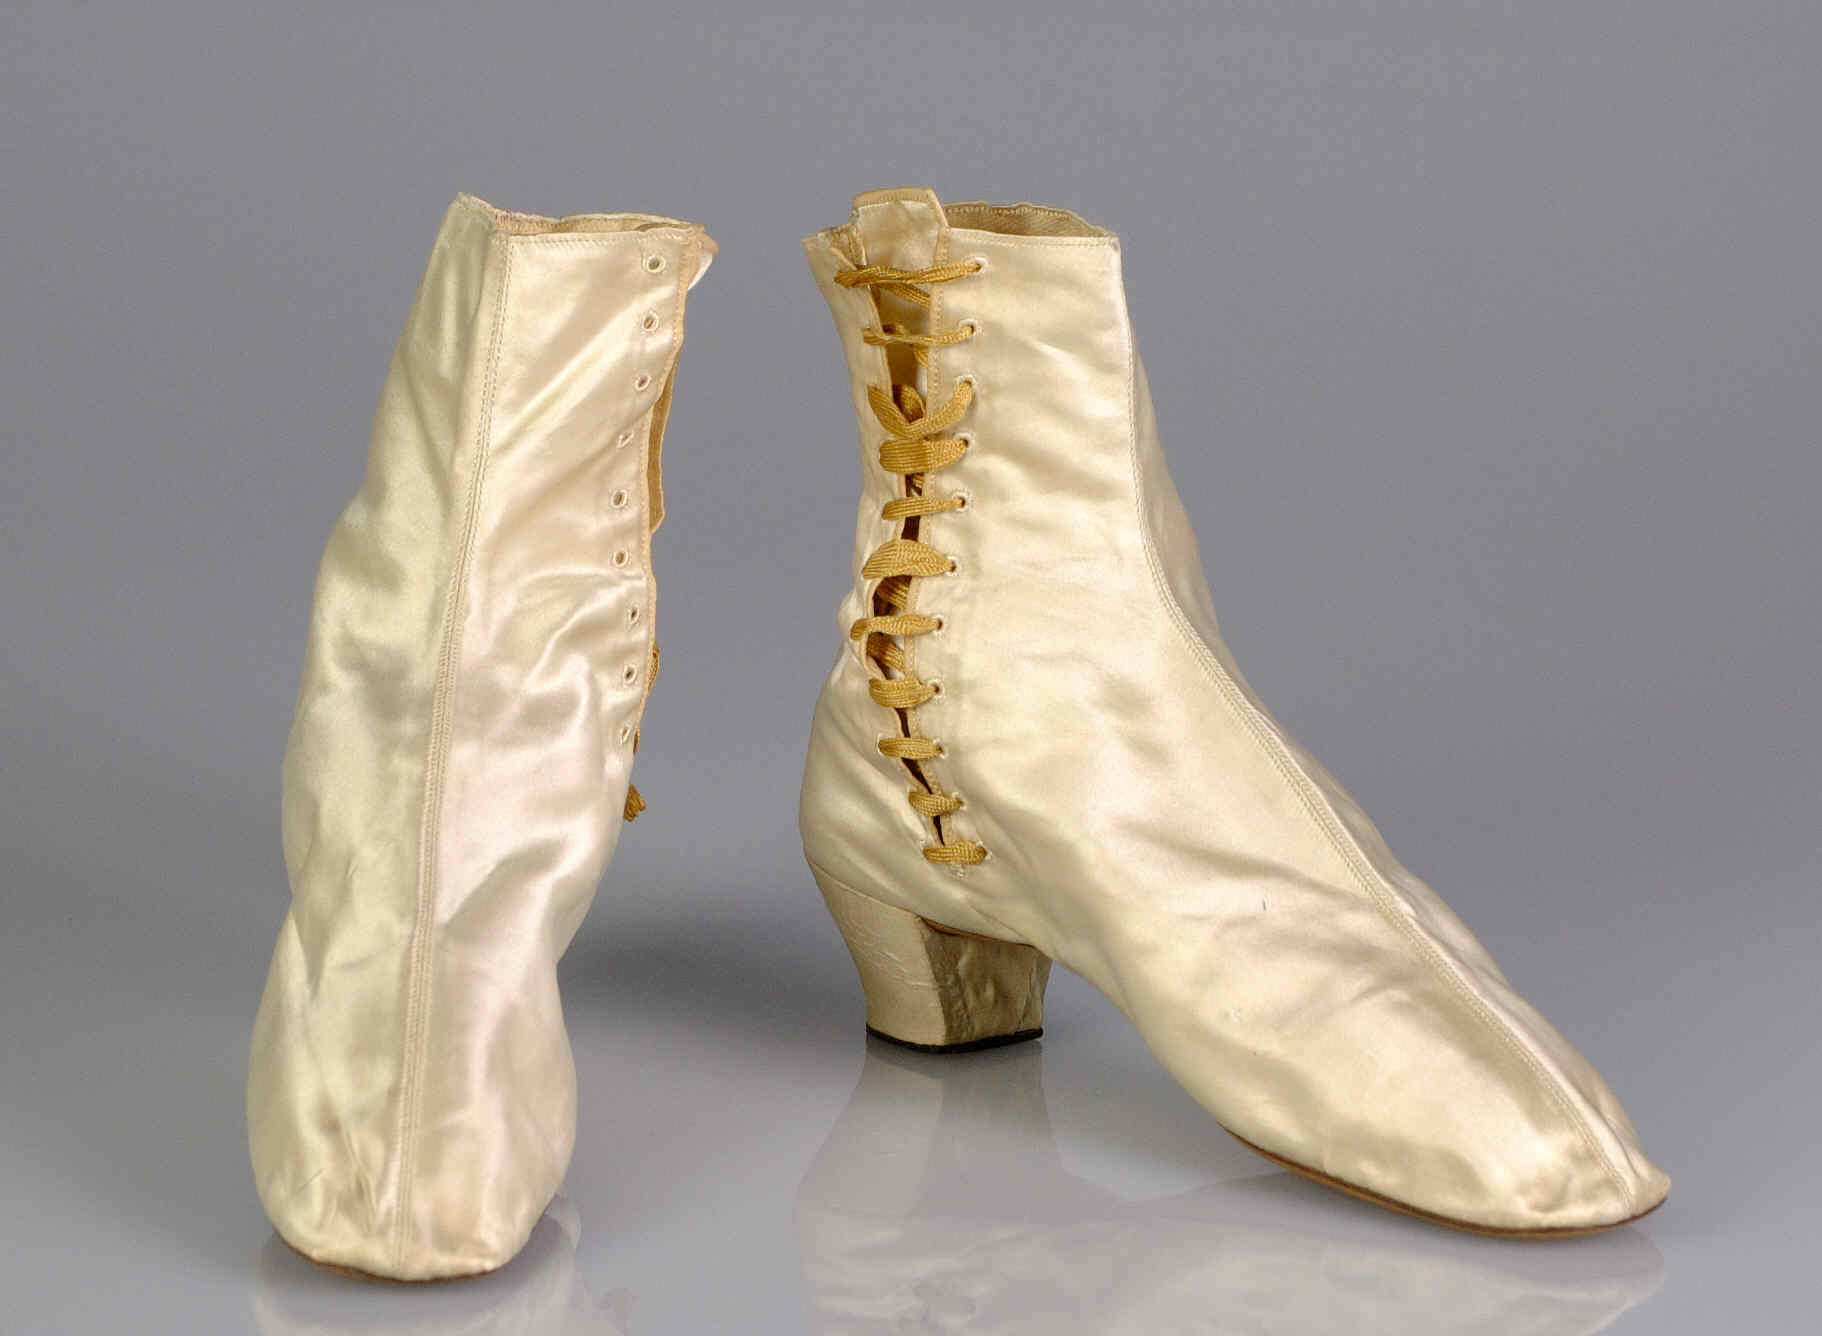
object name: evening boot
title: Evening boots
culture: american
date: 1860-1880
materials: silk